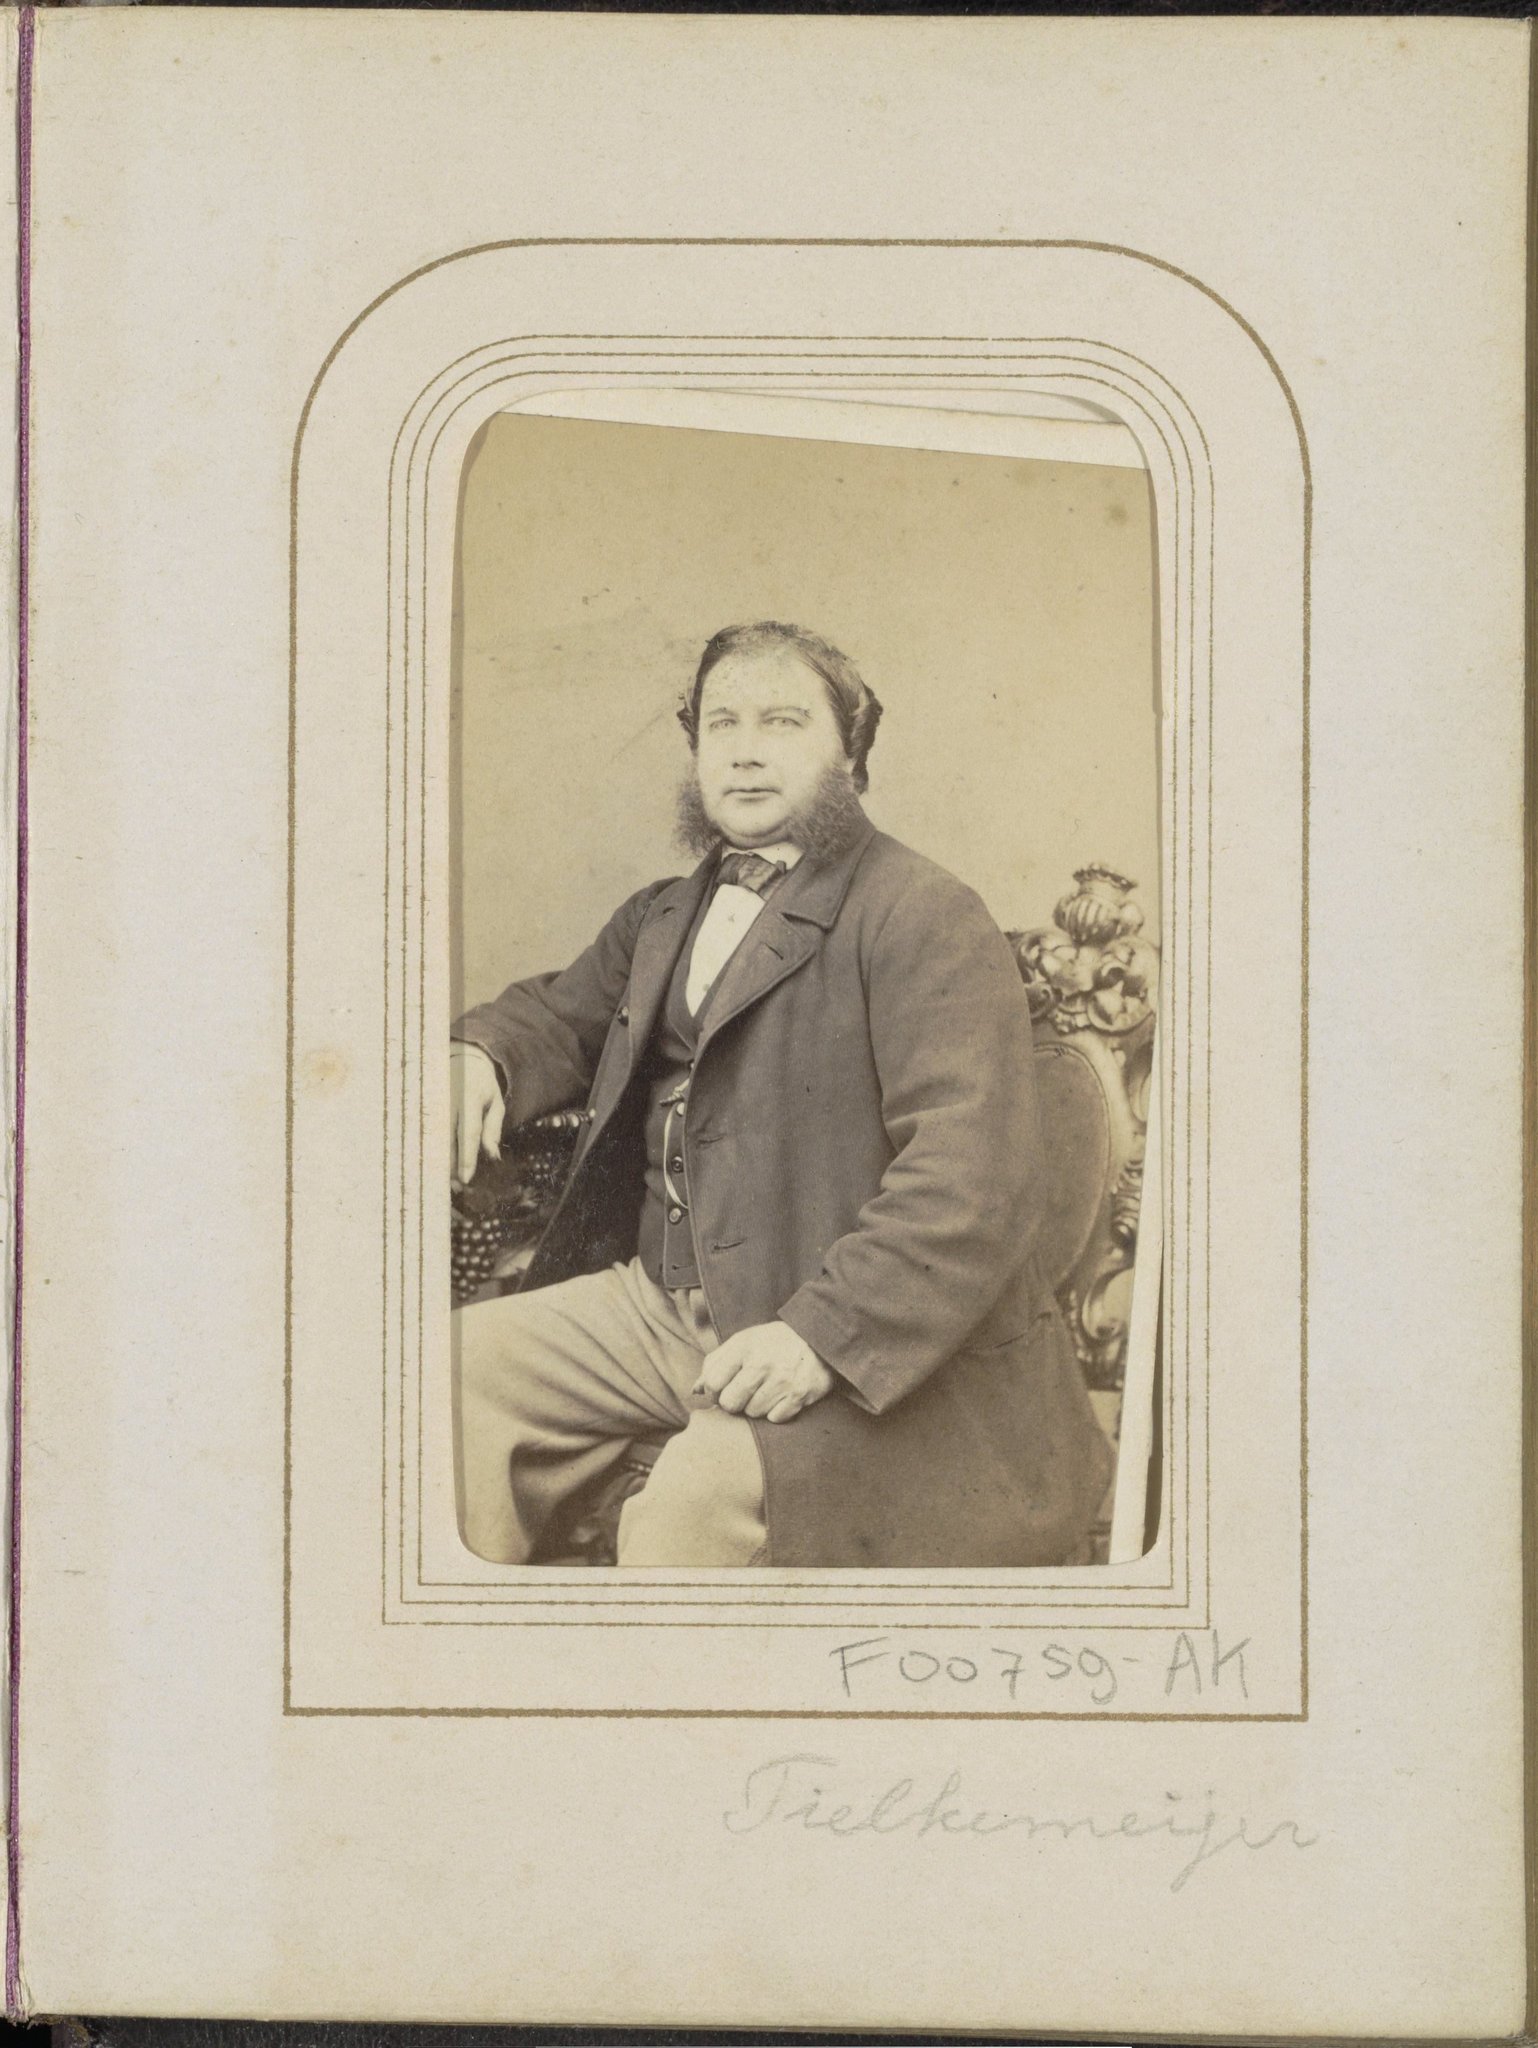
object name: photograph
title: Portret van Jan Herman Adolph Tielkemeijer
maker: franz wilhelm deutmann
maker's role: fotograaf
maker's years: 1809-1895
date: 1860-1875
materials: cardboard, paper, photographic support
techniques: albumen print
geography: amsterdam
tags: studio requisites ~ photographer, historical persons, amsterdam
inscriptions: address: ‘Amsterdam’, inscription: ‘Tielkemeijer’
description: Onderdeel van Fotoalbum van een Nederlandse familie met 50 cartes-de-visite.